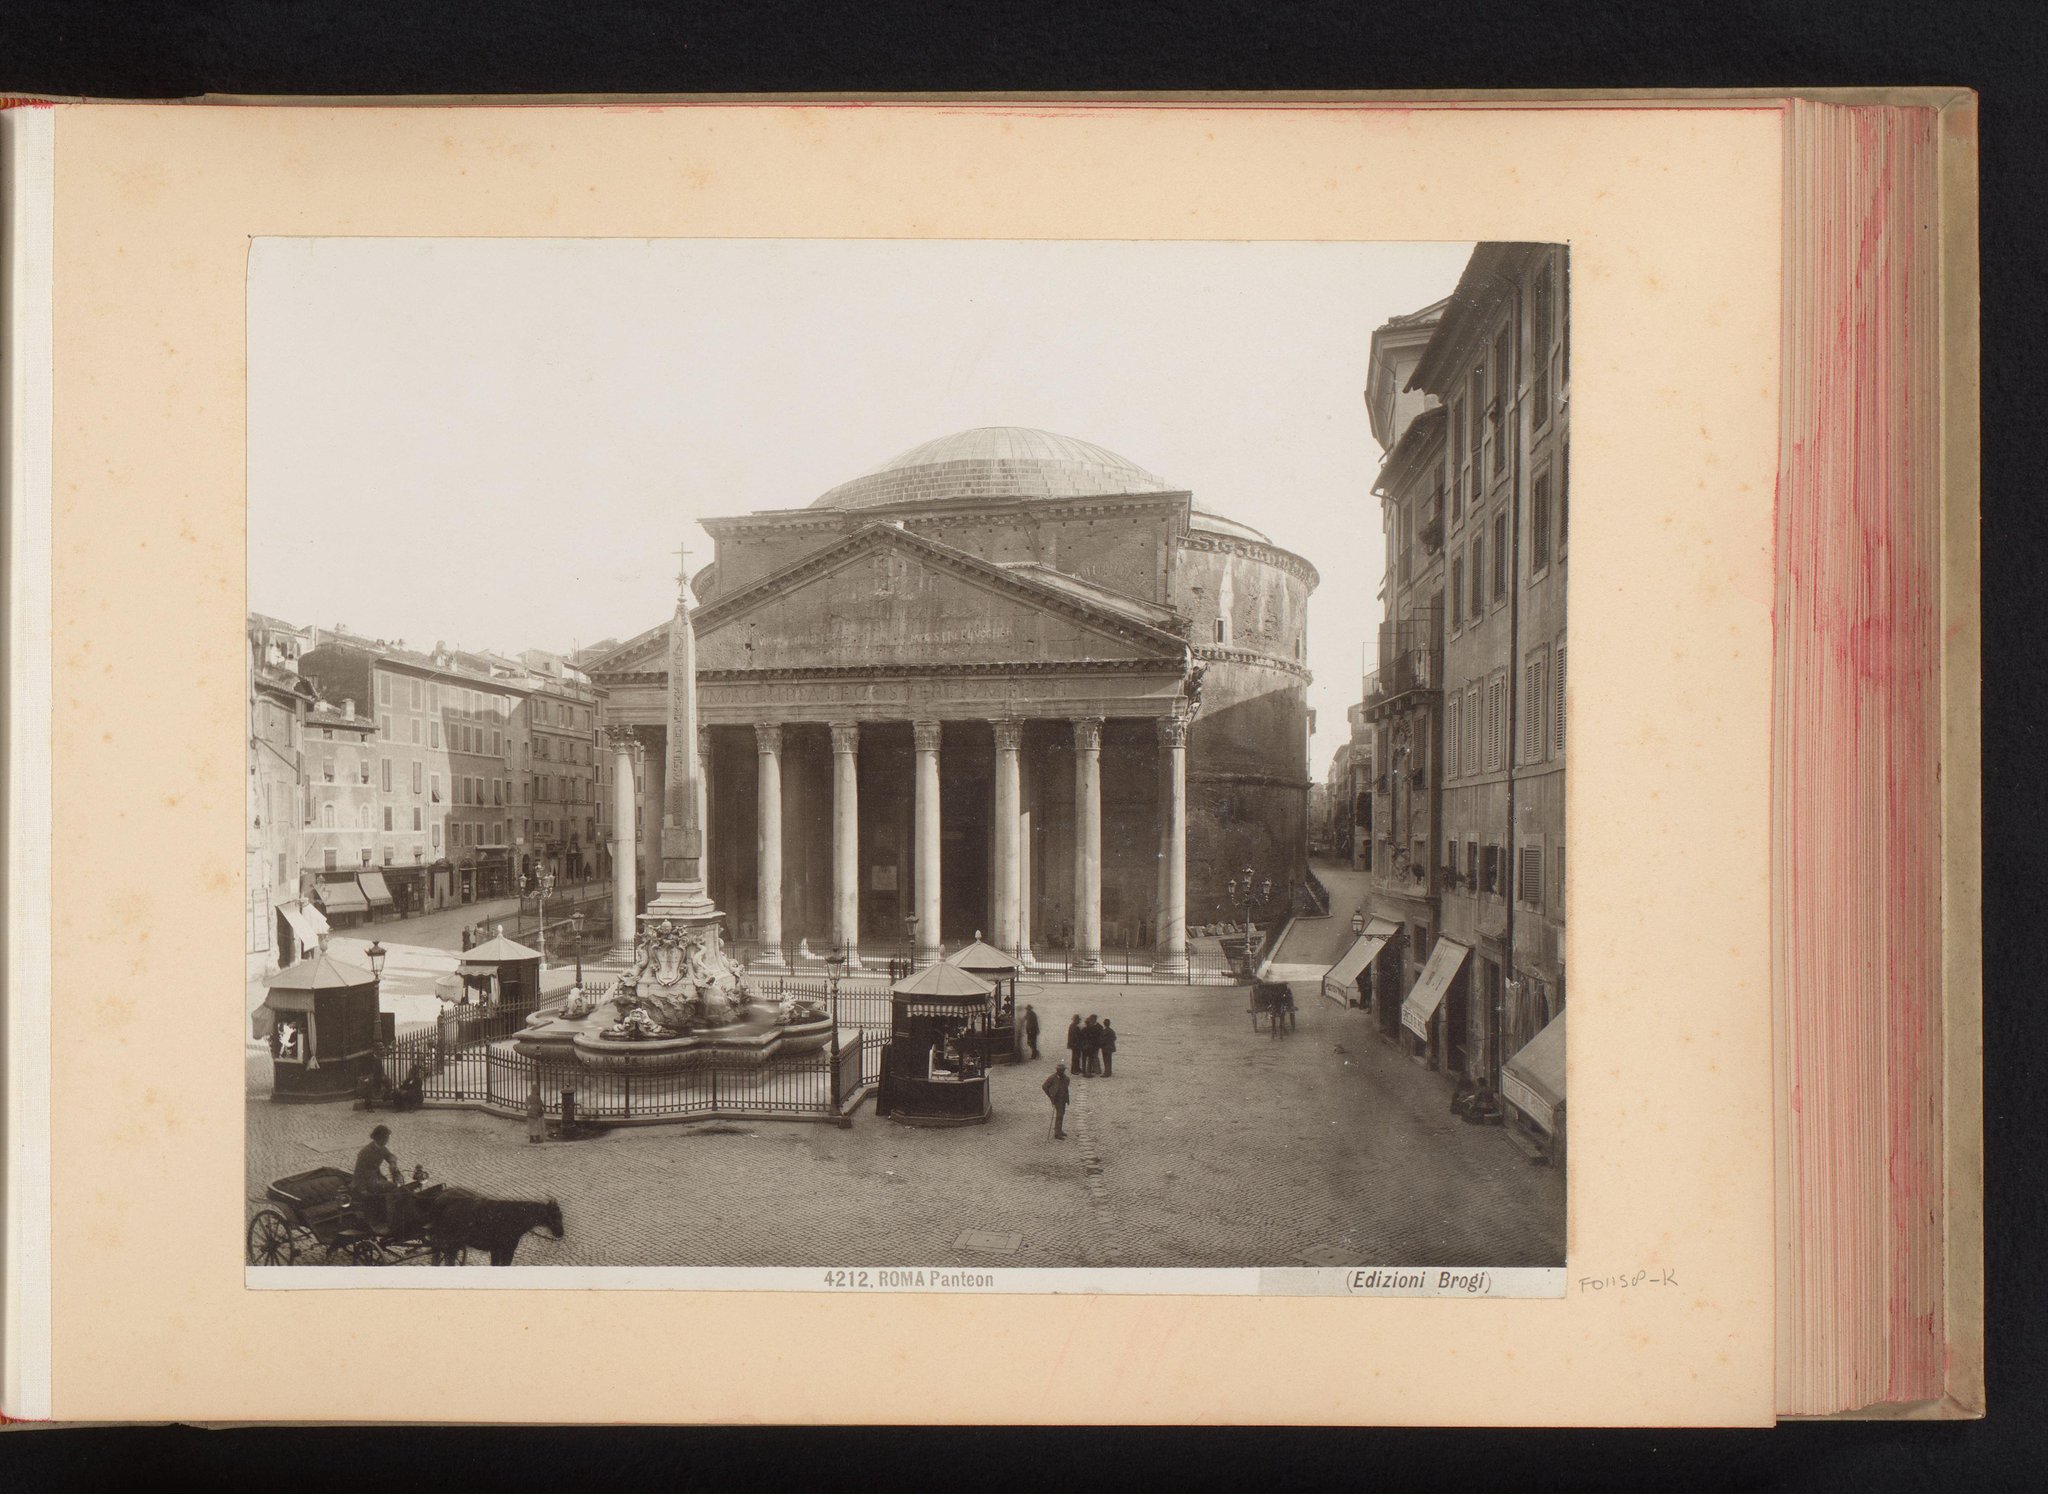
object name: photograph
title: Voorgevel van het Pantheon te Rome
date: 1875-1907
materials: photographic support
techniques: gelatin silver print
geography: piazza della rotonda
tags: square, place, circus, etc., church (exterior), façade (of house or building)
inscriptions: number: ‘4212’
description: Onderdeel van Fotoalbum met opnames van bezienswaardigheden en kunstwerken in Italië.